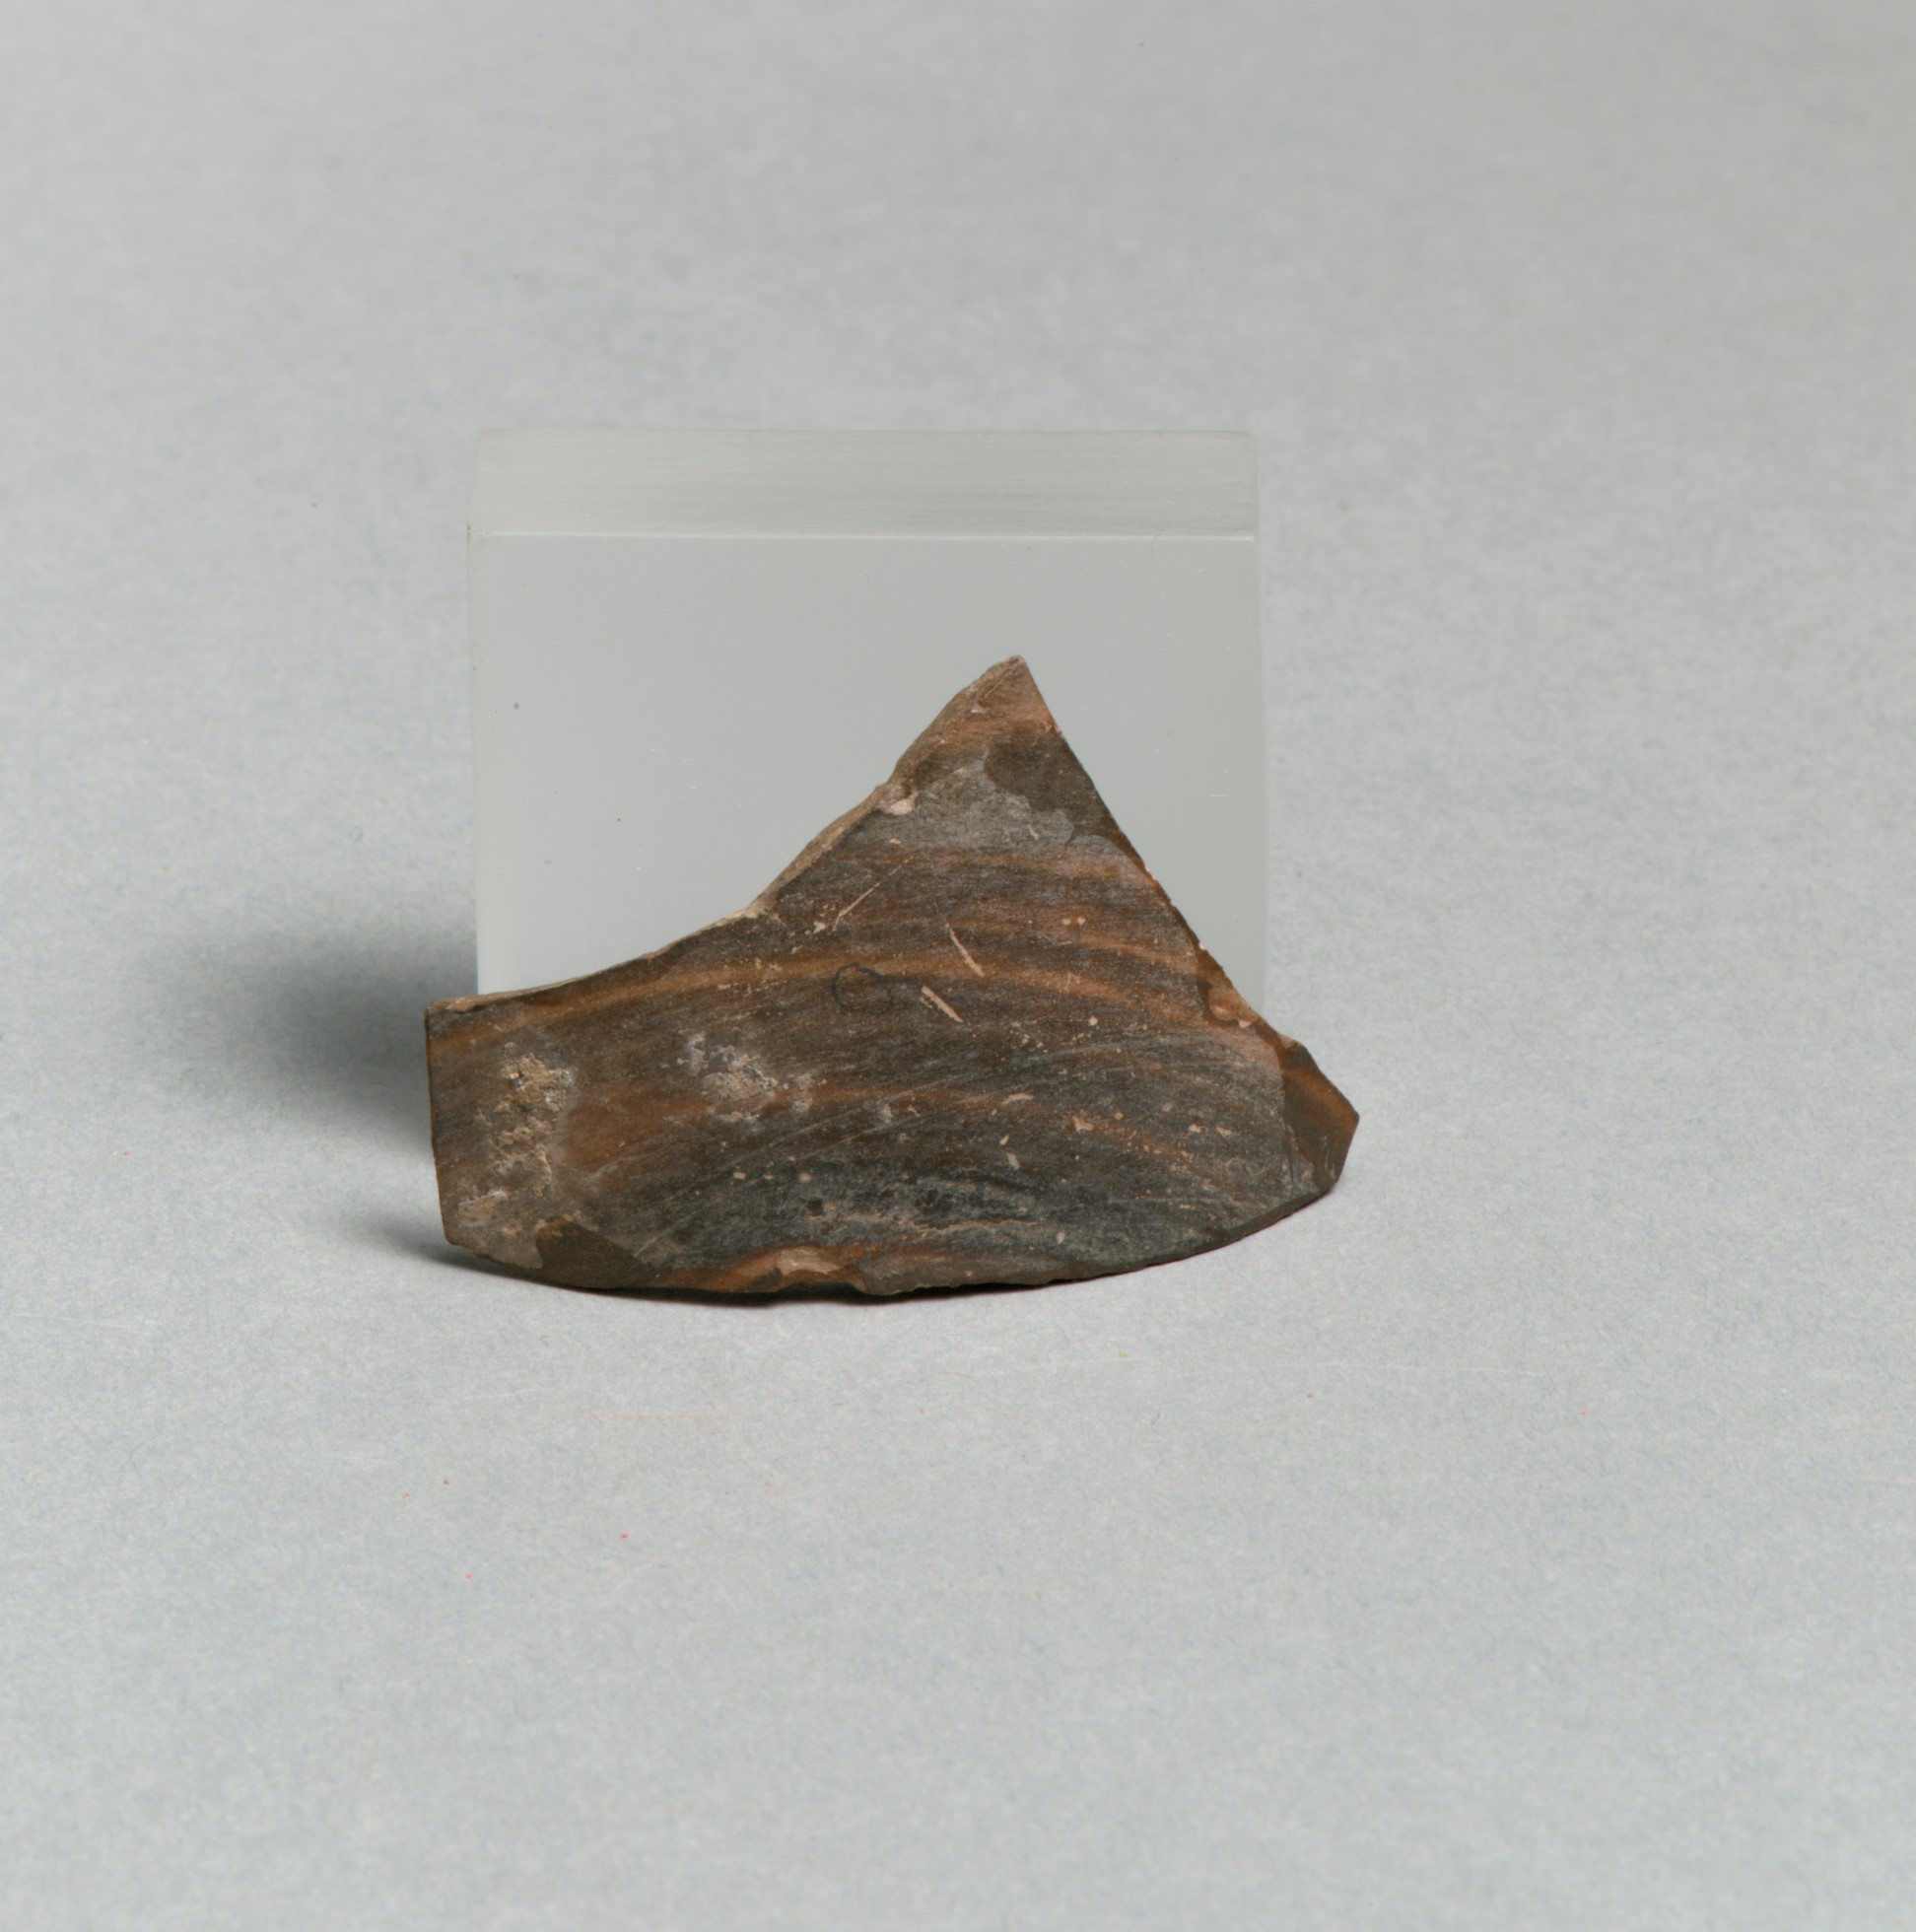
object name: vase fragment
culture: greek or lydian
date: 900-30 BCE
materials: terracotta